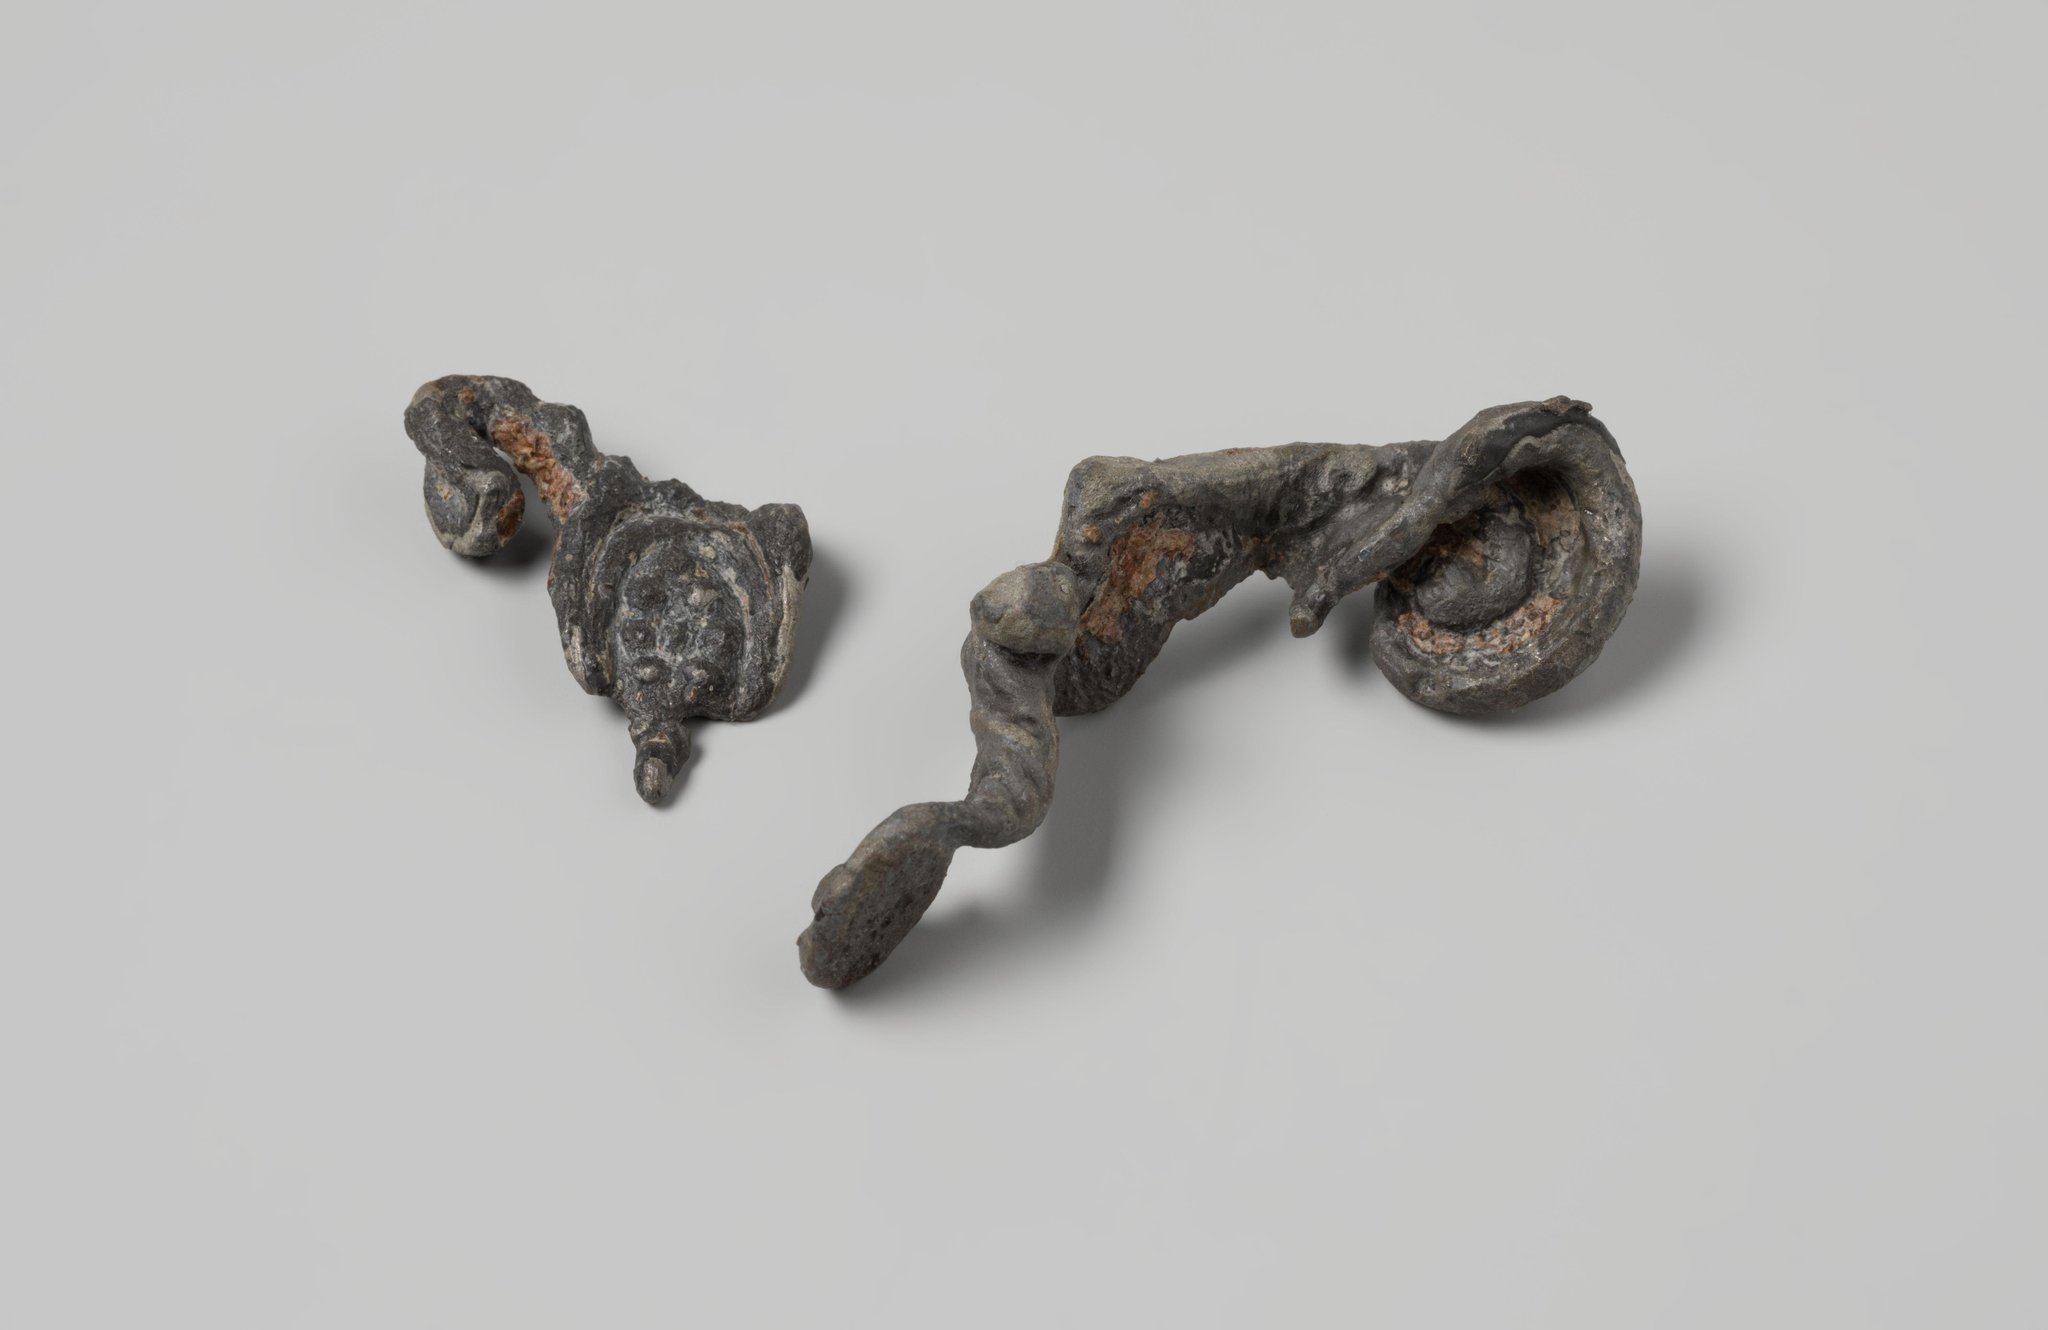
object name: beslag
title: Decoratief beslag uit het wrak van de Oost-Indiëvaarder Hollandia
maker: Anonymous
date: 1700-1743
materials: lead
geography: netherlands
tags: verenigde oostindische compagnie, hollandia (schip), annet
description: Fitting, decorative fitting or fragment; fragm, central excutcheon and left scroll, id. NG 1980-27H1133, squashed, eroded.